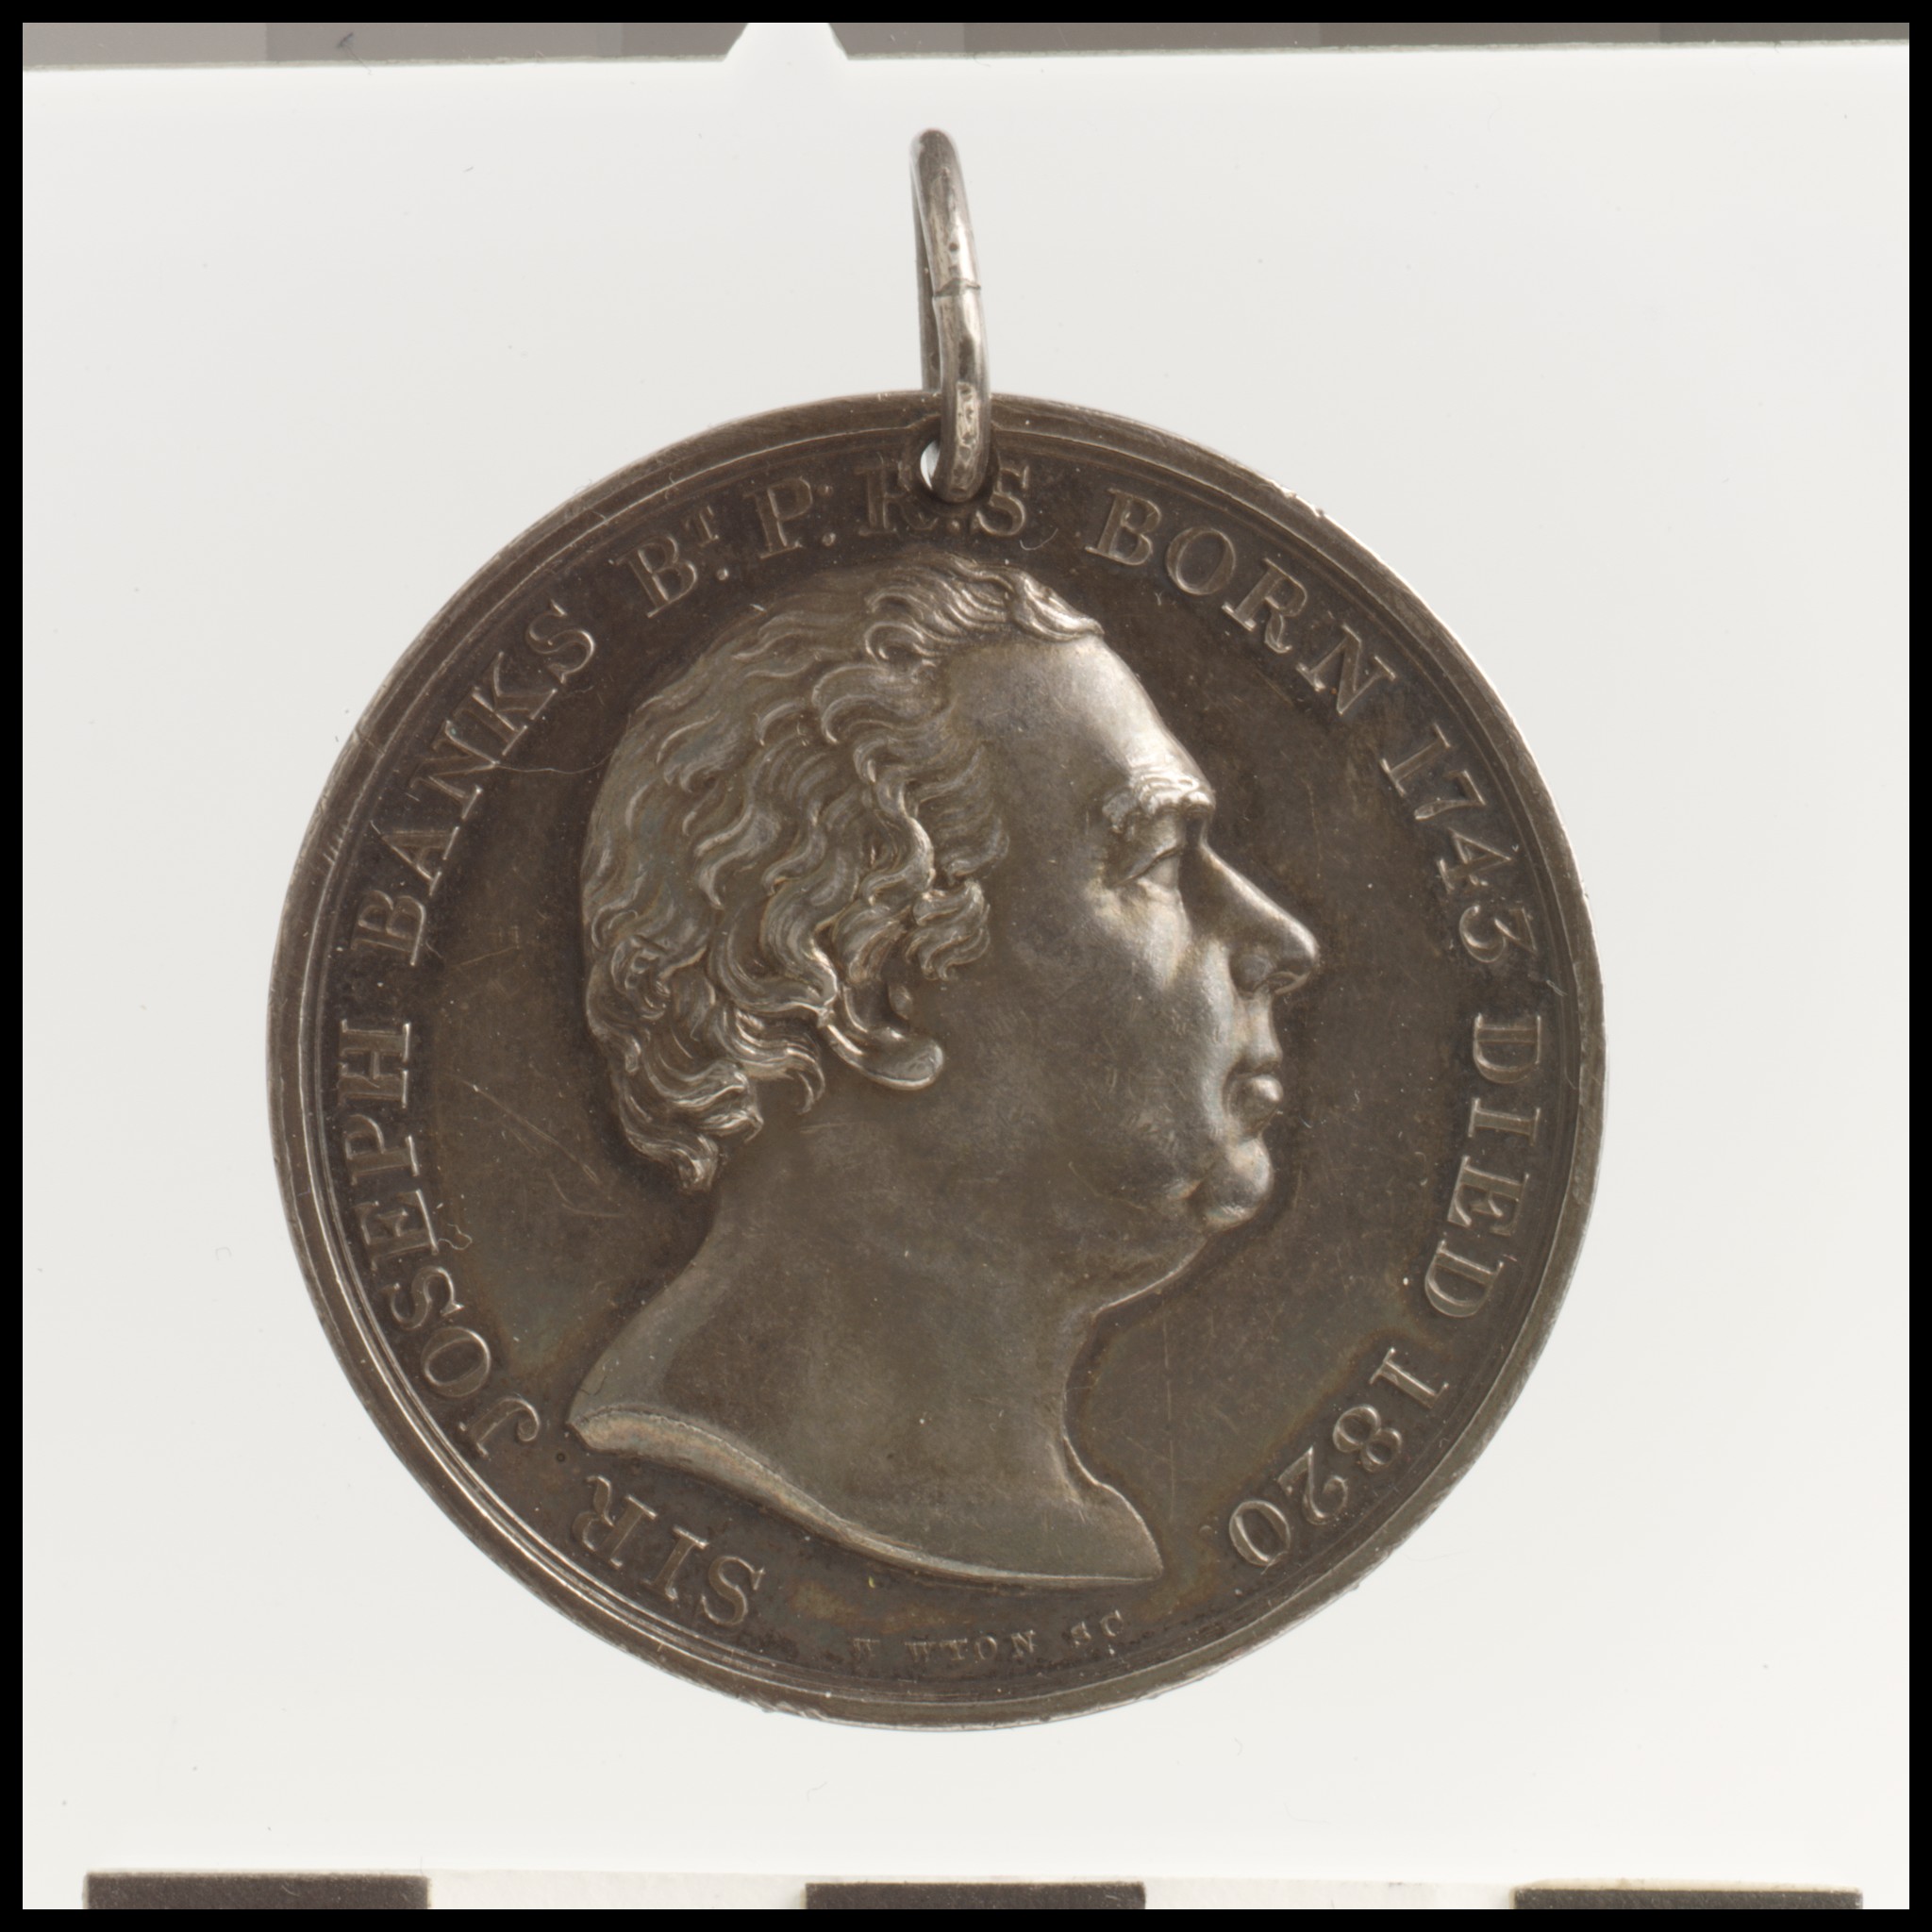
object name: medal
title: Sir Joseph Banks (1743–1820)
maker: william wyon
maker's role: artist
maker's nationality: british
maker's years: 1795-1851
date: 1837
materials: silver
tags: men,profiles